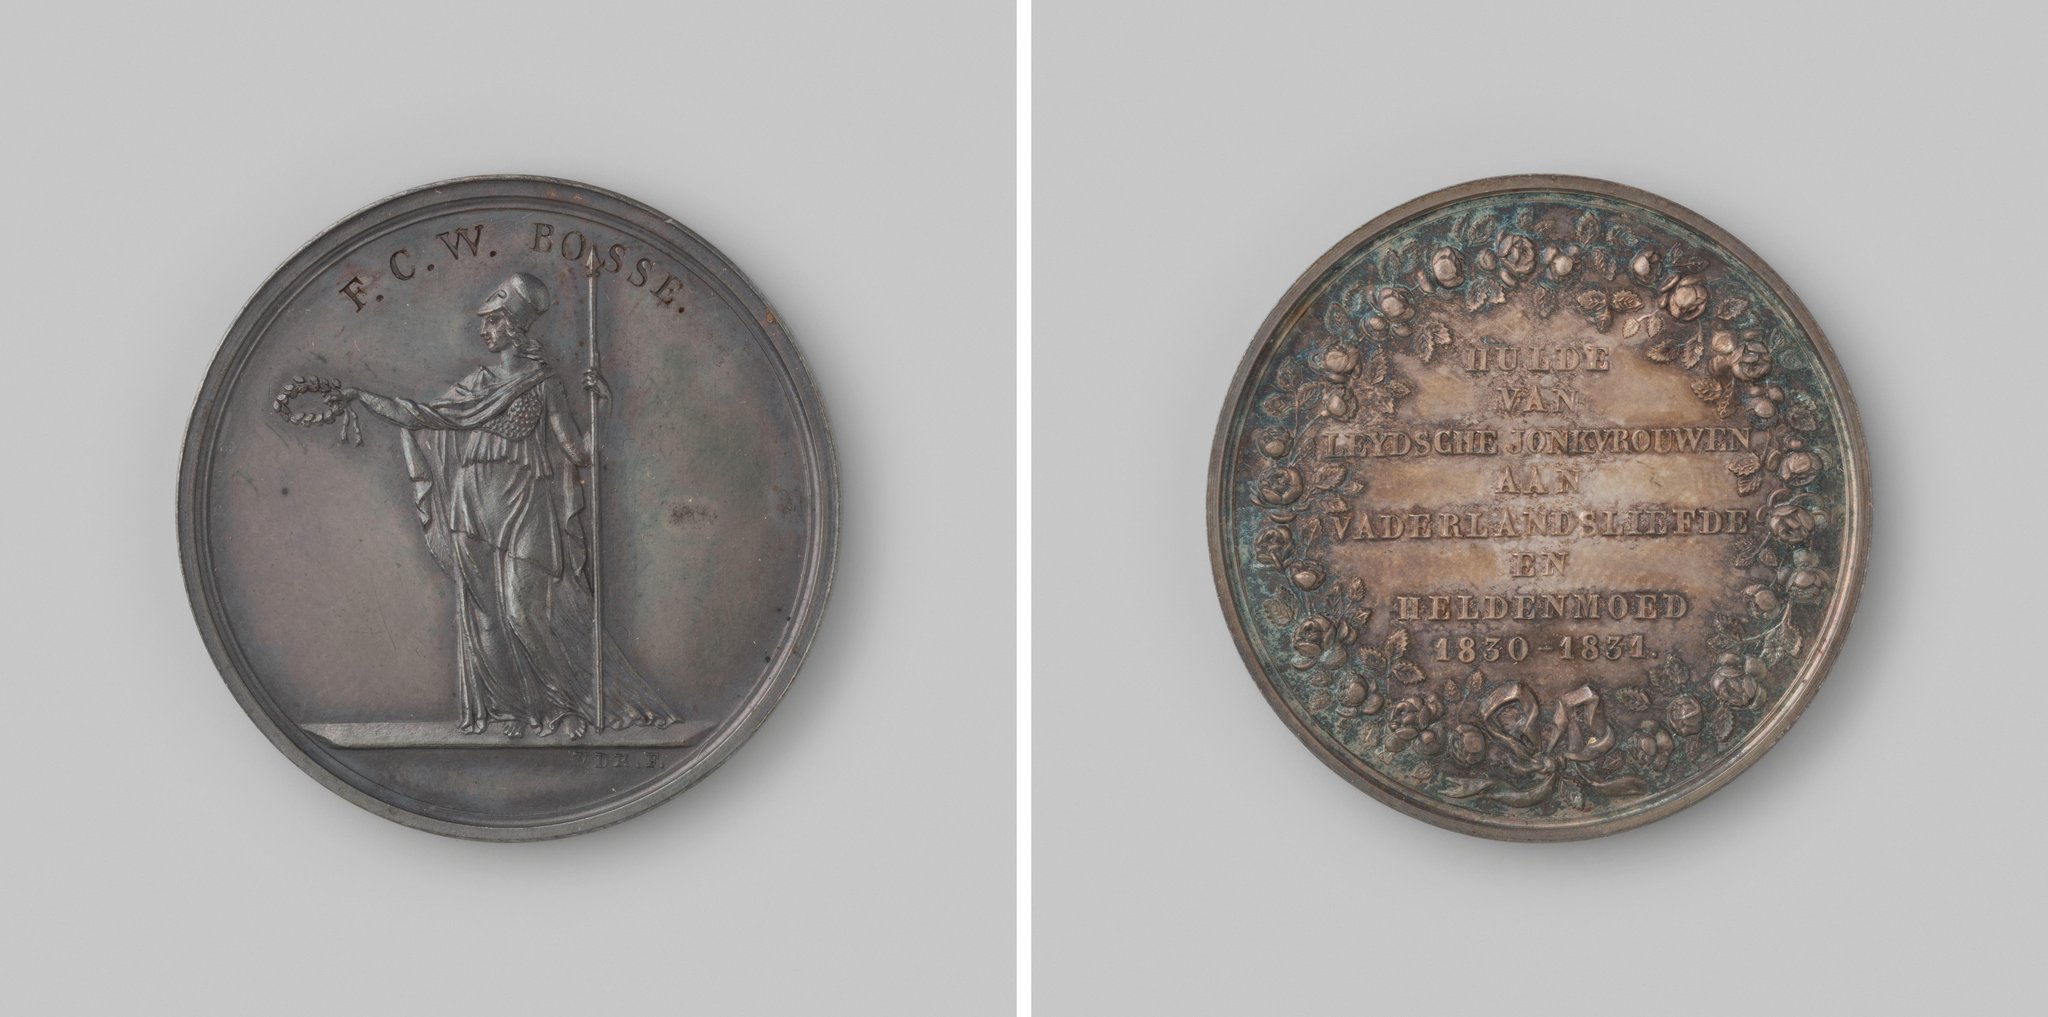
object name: history medal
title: Hulde van Leidse jonkvrouwen aan de uitgetrokken Leidse studenten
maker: david van der kellen (1804-1879)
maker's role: die cutter, draughtsman, print maker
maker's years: 1804-1879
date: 1831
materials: bronze